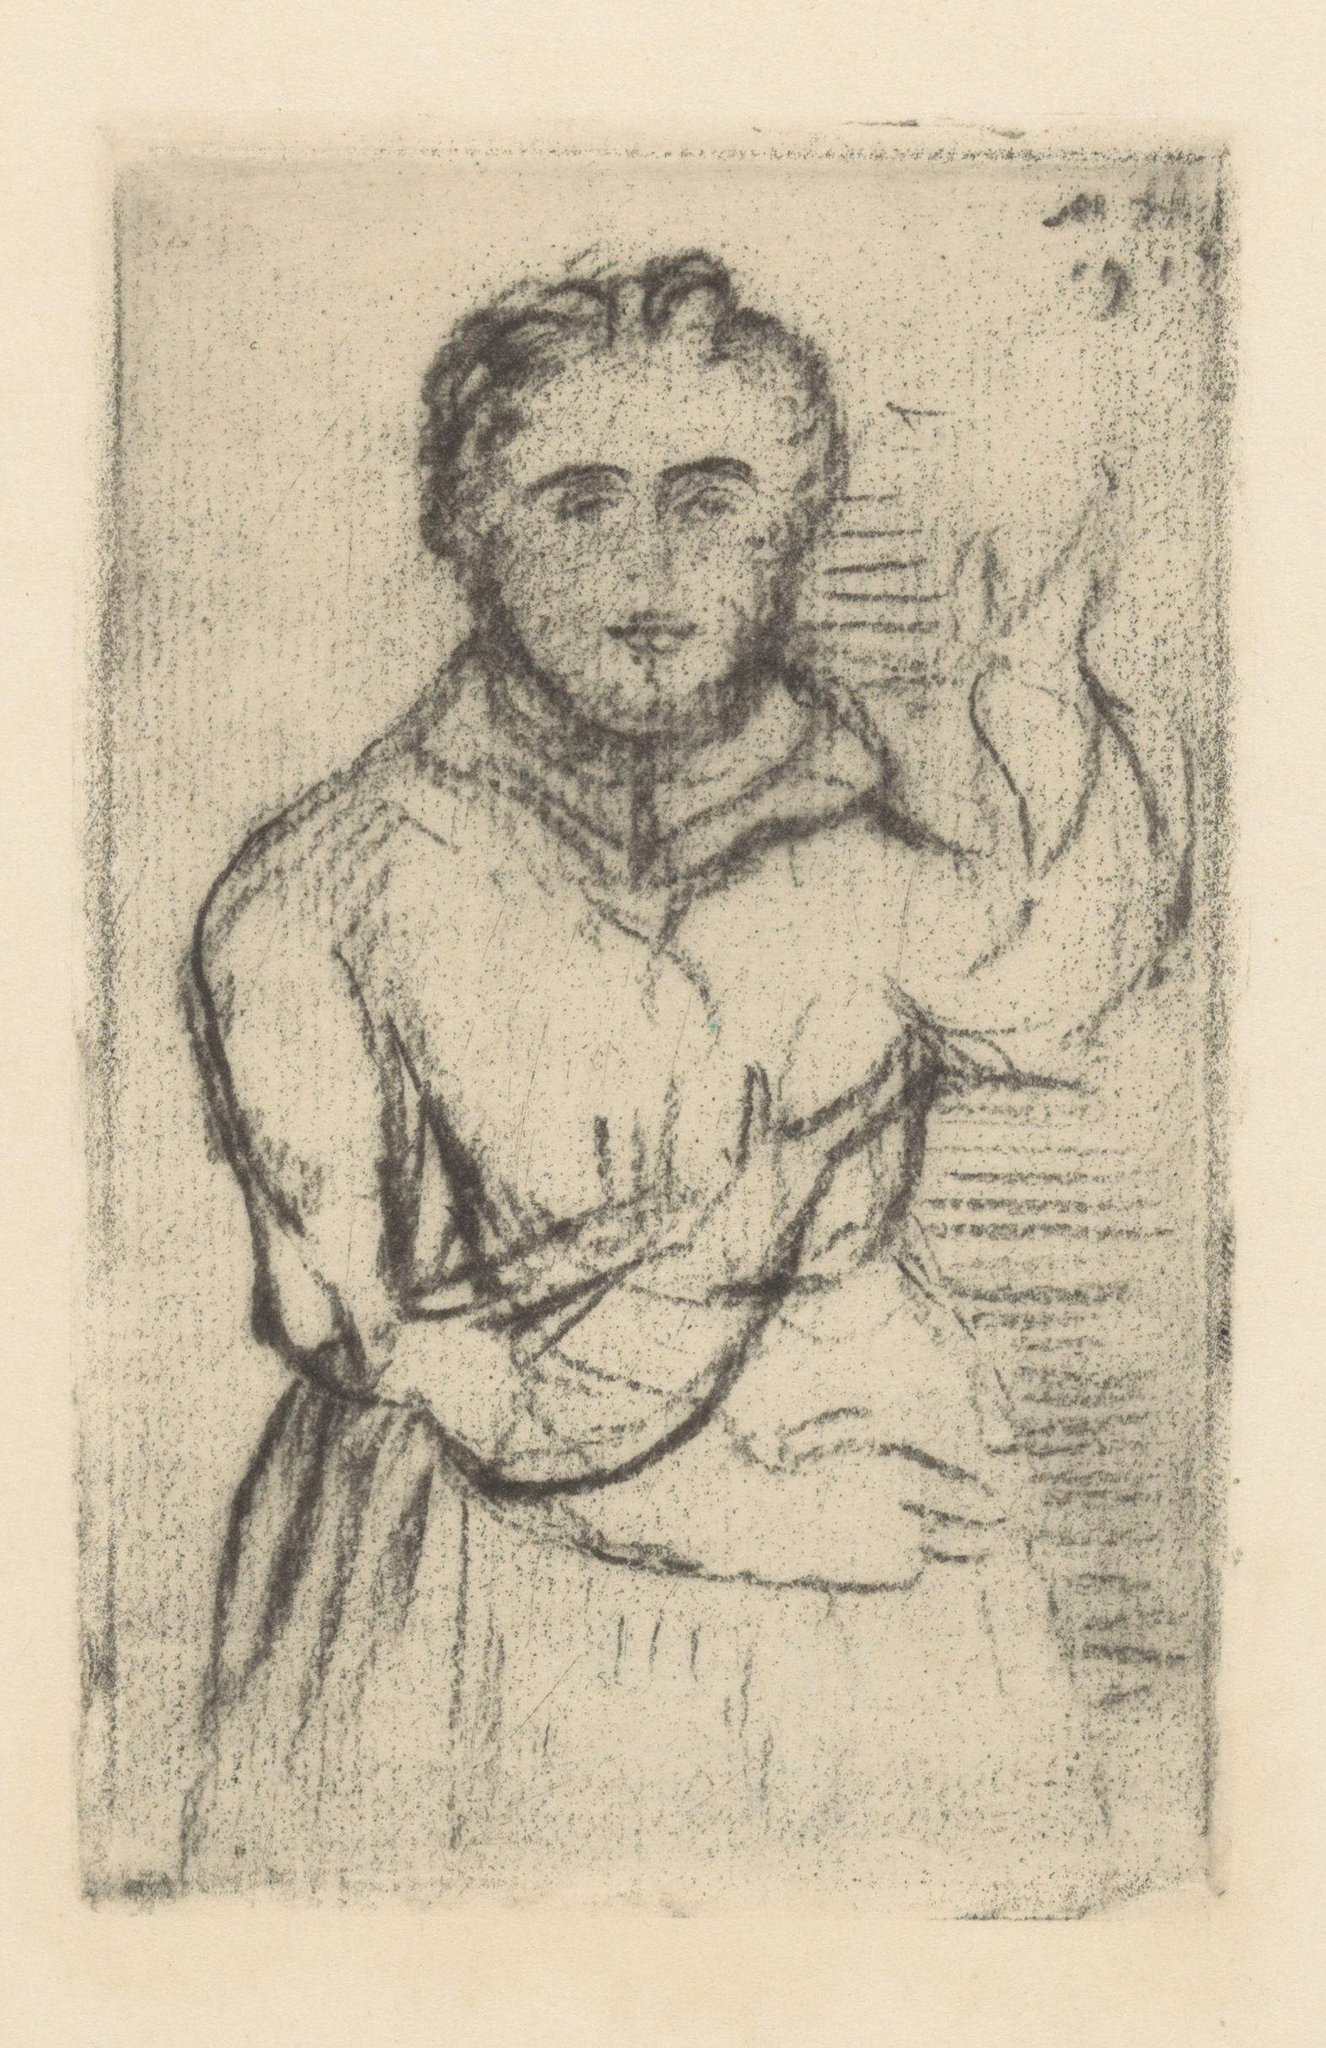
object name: print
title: Staande vrouw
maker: marius holleman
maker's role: draughtsman, print maker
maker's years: 1878-1926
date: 1919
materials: paper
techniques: etching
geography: groningen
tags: arm raised upward, adult woman, arm or hand held in front of the body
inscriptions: collector's mark: Lugt 2228